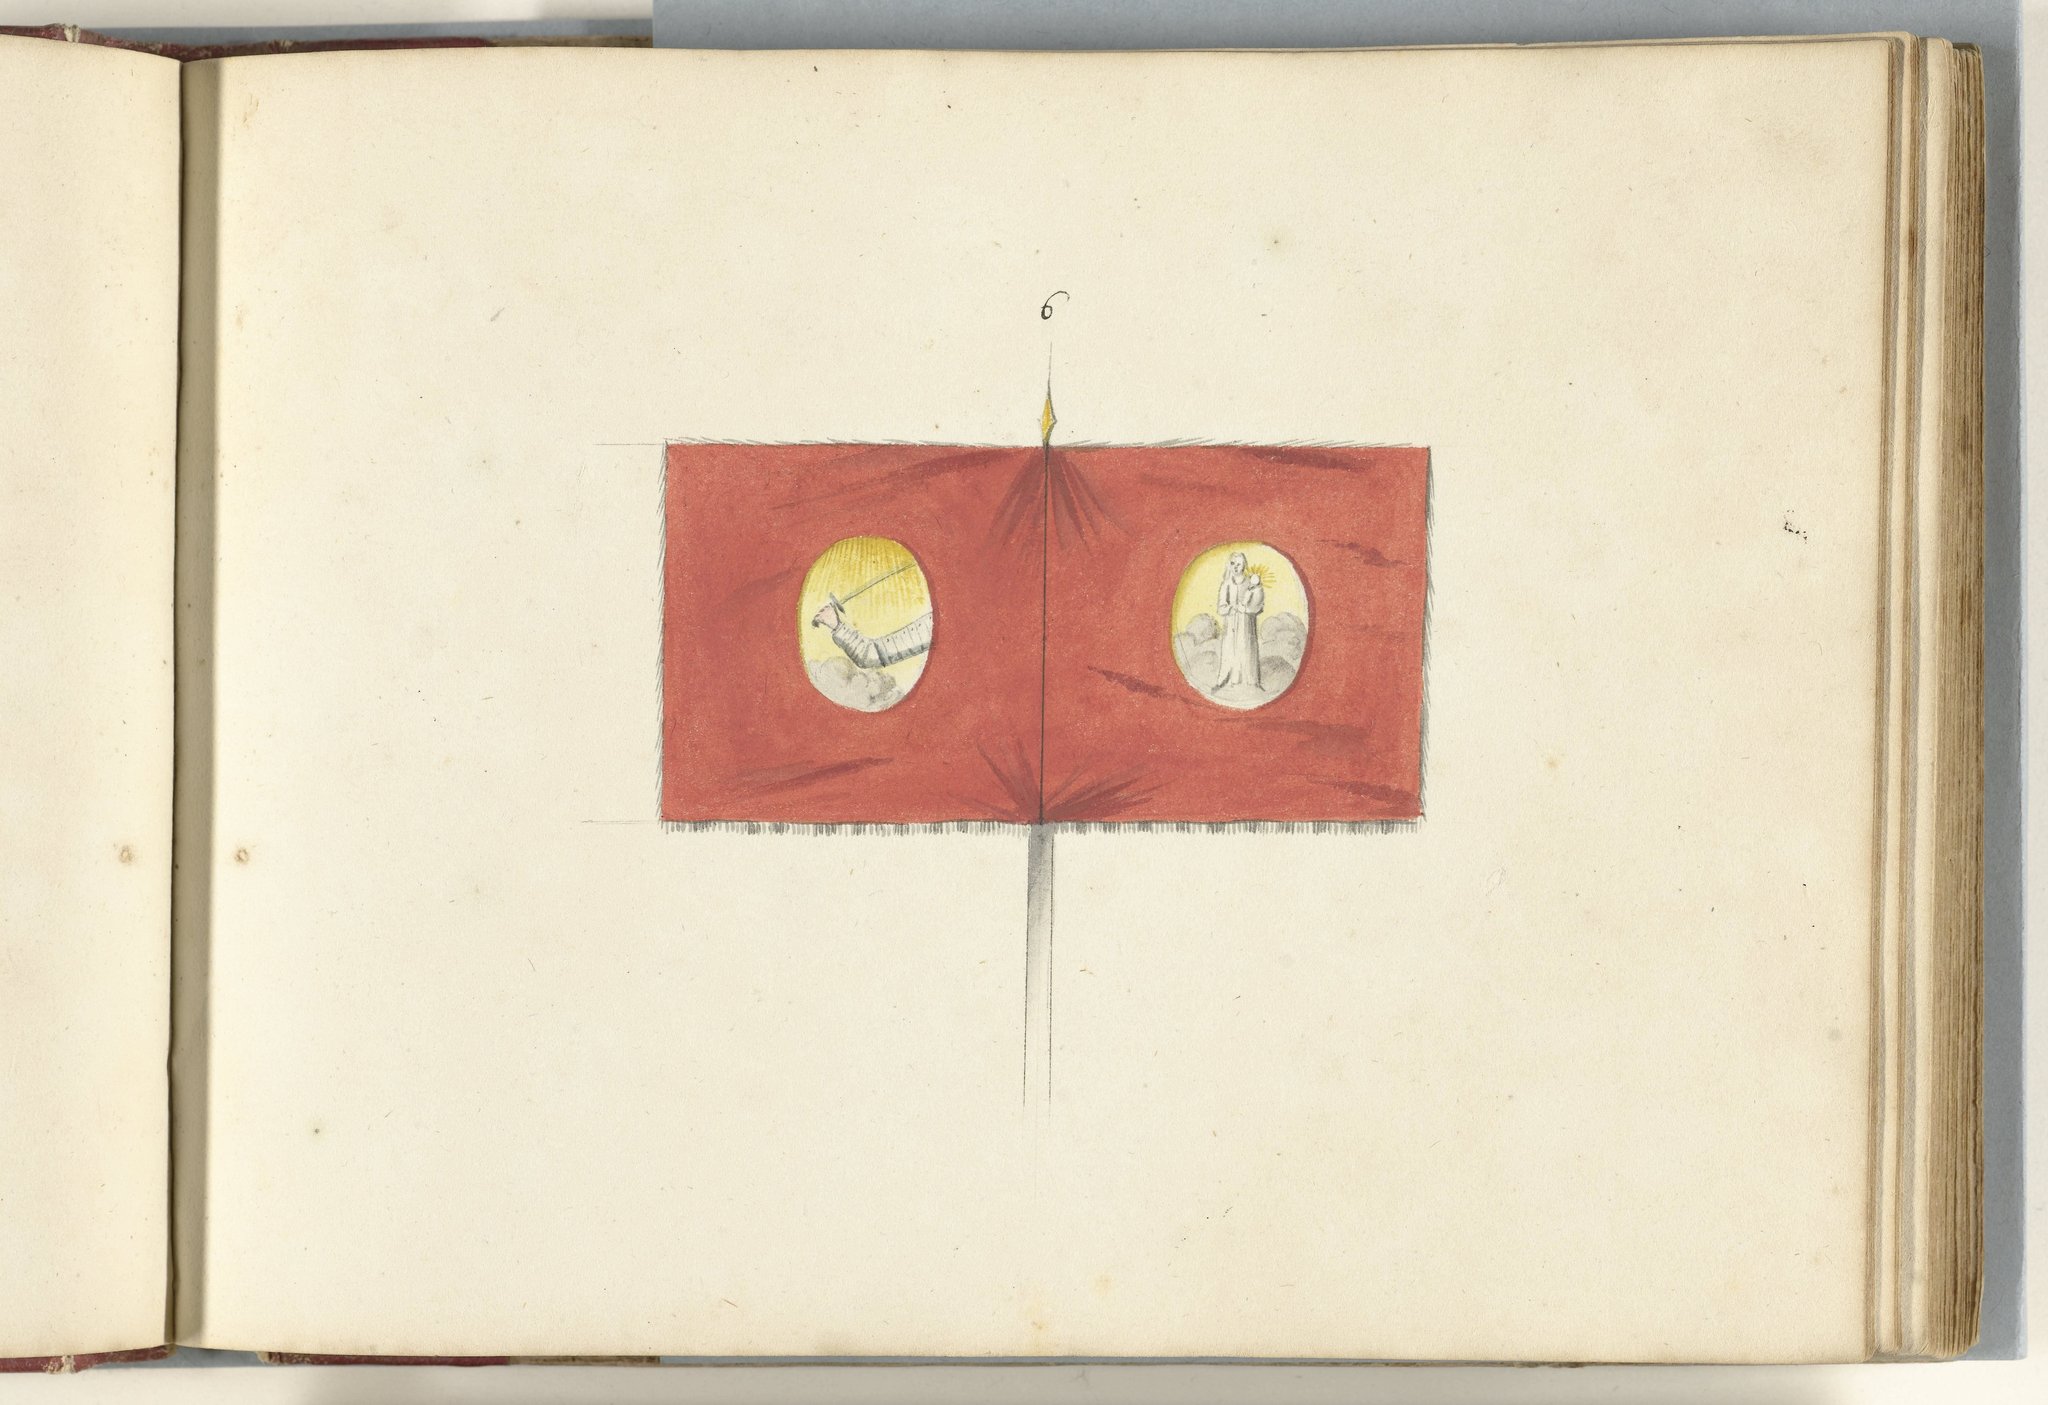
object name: drawing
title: Frans standaard veroverd bij de slag bij Ramillies, 1706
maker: Anonymous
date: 1713-1720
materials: paper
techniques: drawing, writing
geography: northern netherlands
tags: (military) flags and standards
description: Frans standaard veroverd bij de slag bij Ramillies 1706. In het boek met tekeningen van Franse vaandels, standaarden en pauken, veroverd tijdens de Spaanse Successieoorlog (1701-1713).